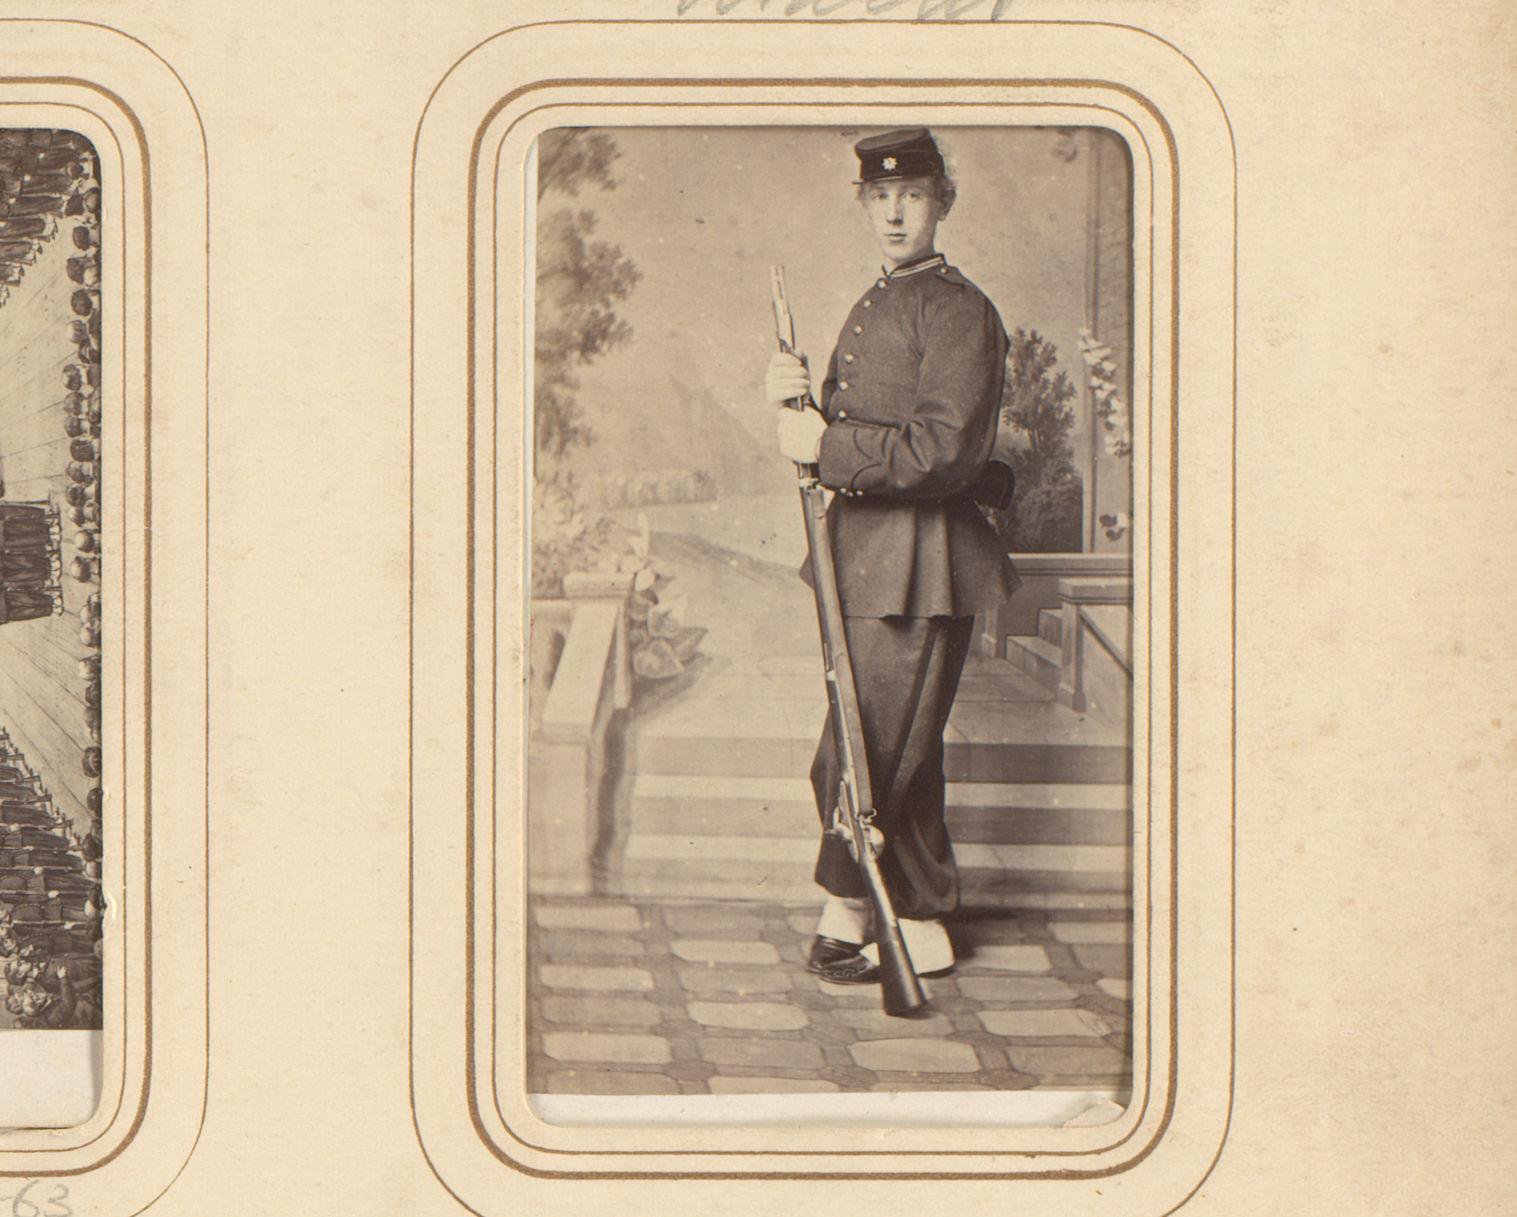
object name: album leaf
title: Portret van een man in militair uniform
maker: willem cornelis van dijk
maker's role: painter, print maker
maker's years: 1826-1881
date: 1865-1875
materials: cardboard, photographic support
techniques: albumen print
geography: utrecht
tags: adult man, (military) uniforms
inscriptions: inscription: ‘W.C. van Dijk / Artiste-peintre / et / Photographe de S.M. le Roi. / Utrecht / Langenieuwstraat / Lett. A, No. 522.’